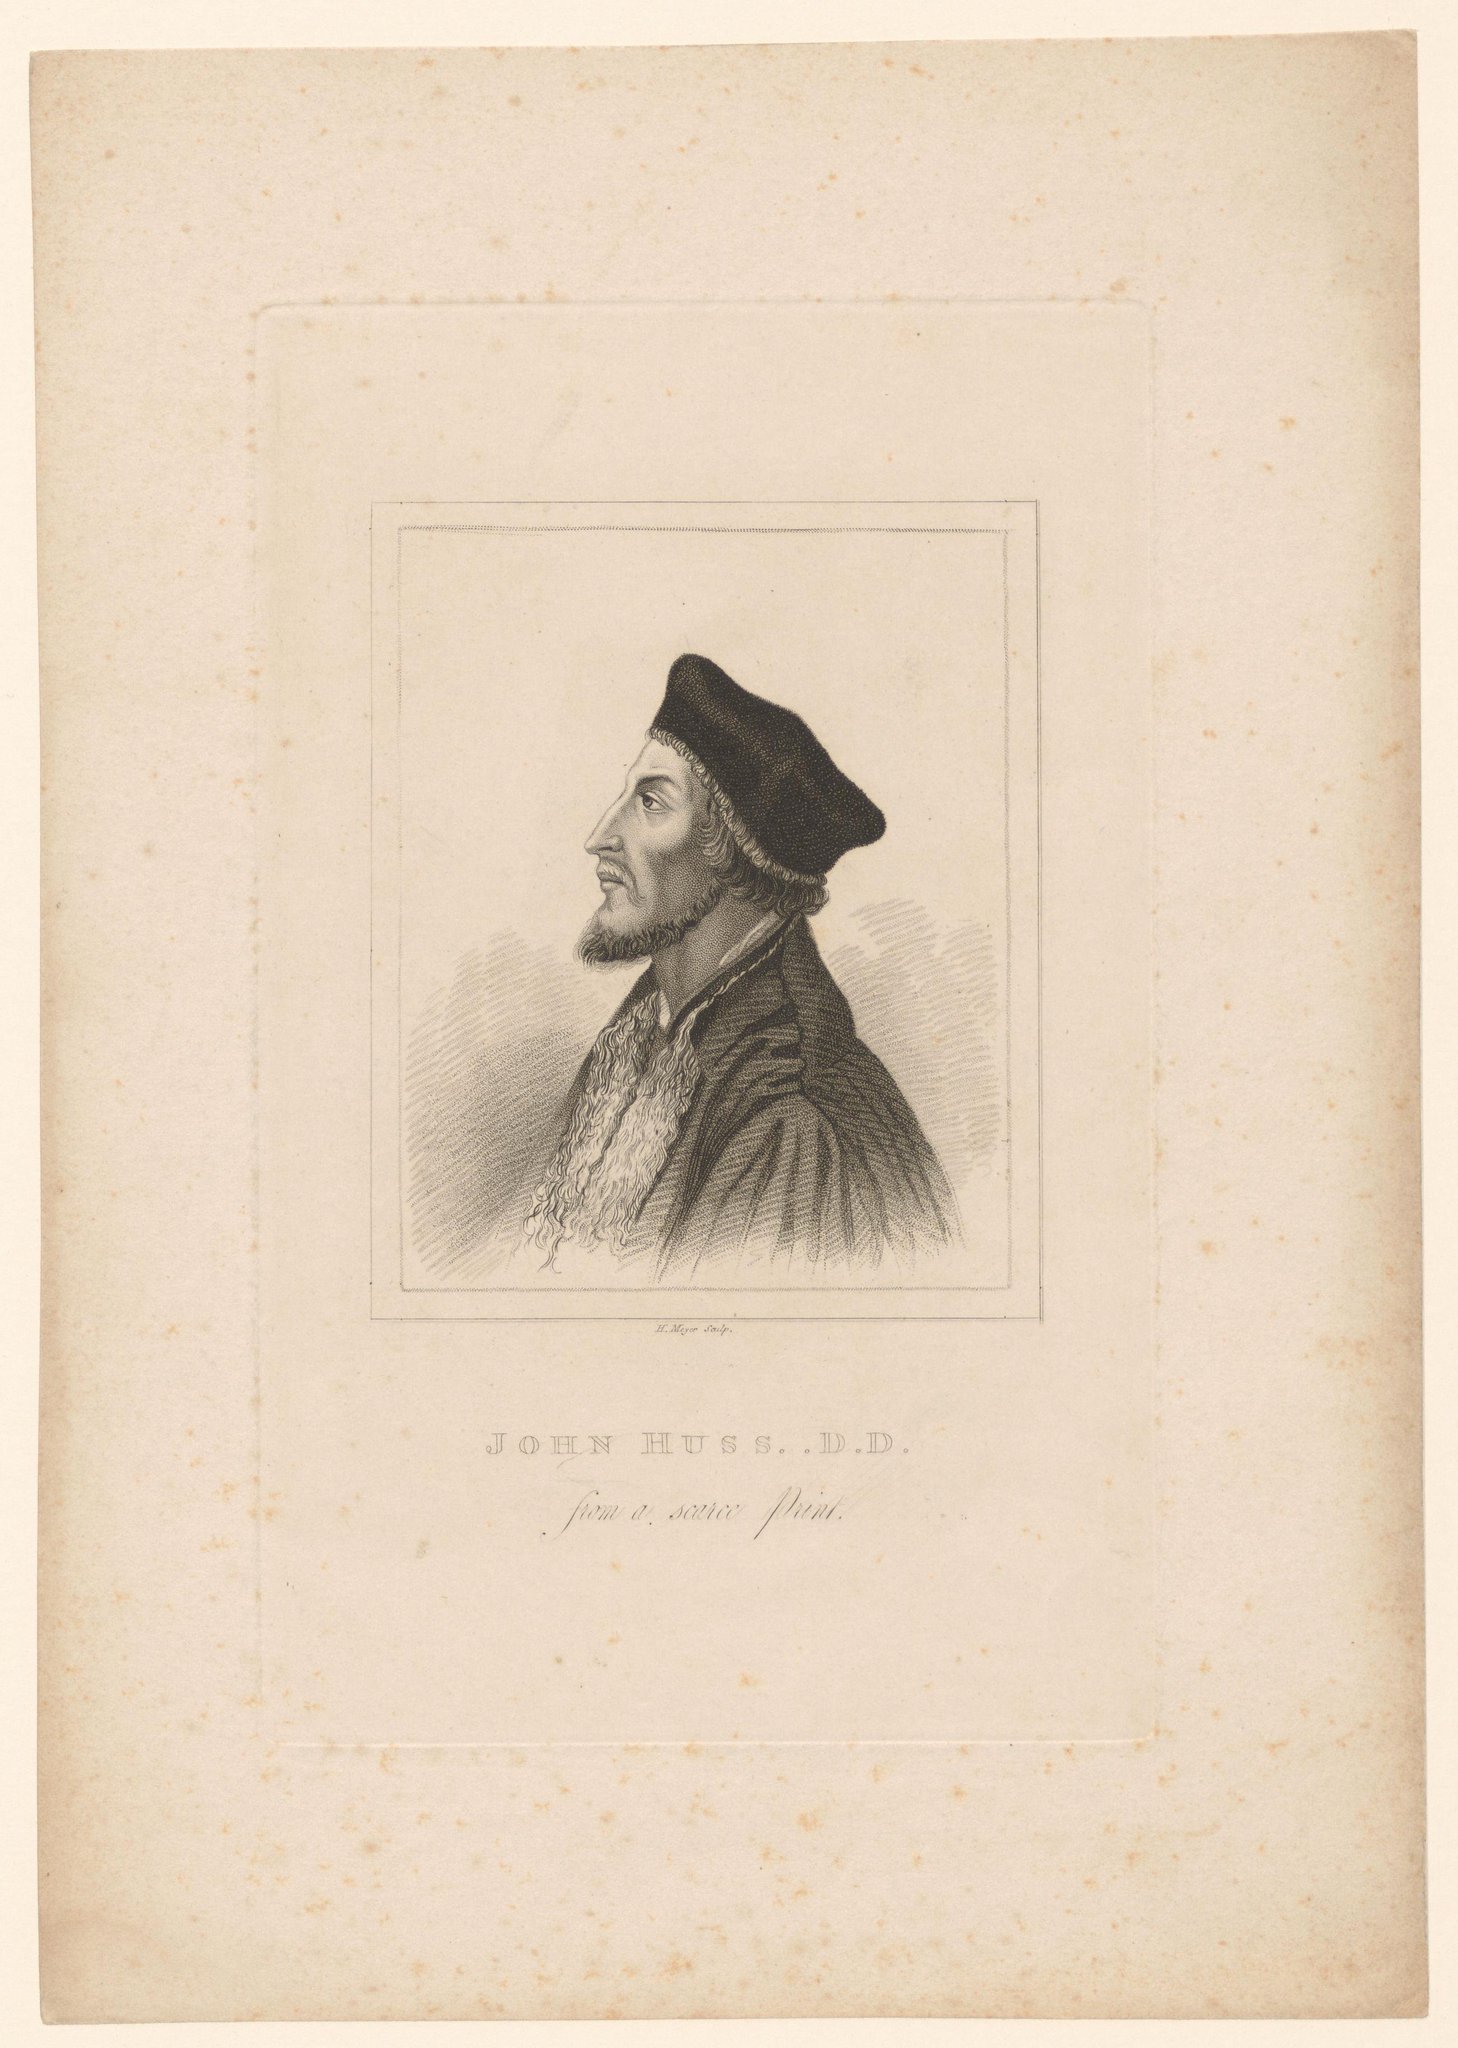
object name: print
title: John Huss D.D.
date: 1820-1830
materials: paper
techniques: etching, roulette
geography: london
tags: theologian, historical persons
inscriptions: collector's mark: Lugt 2228